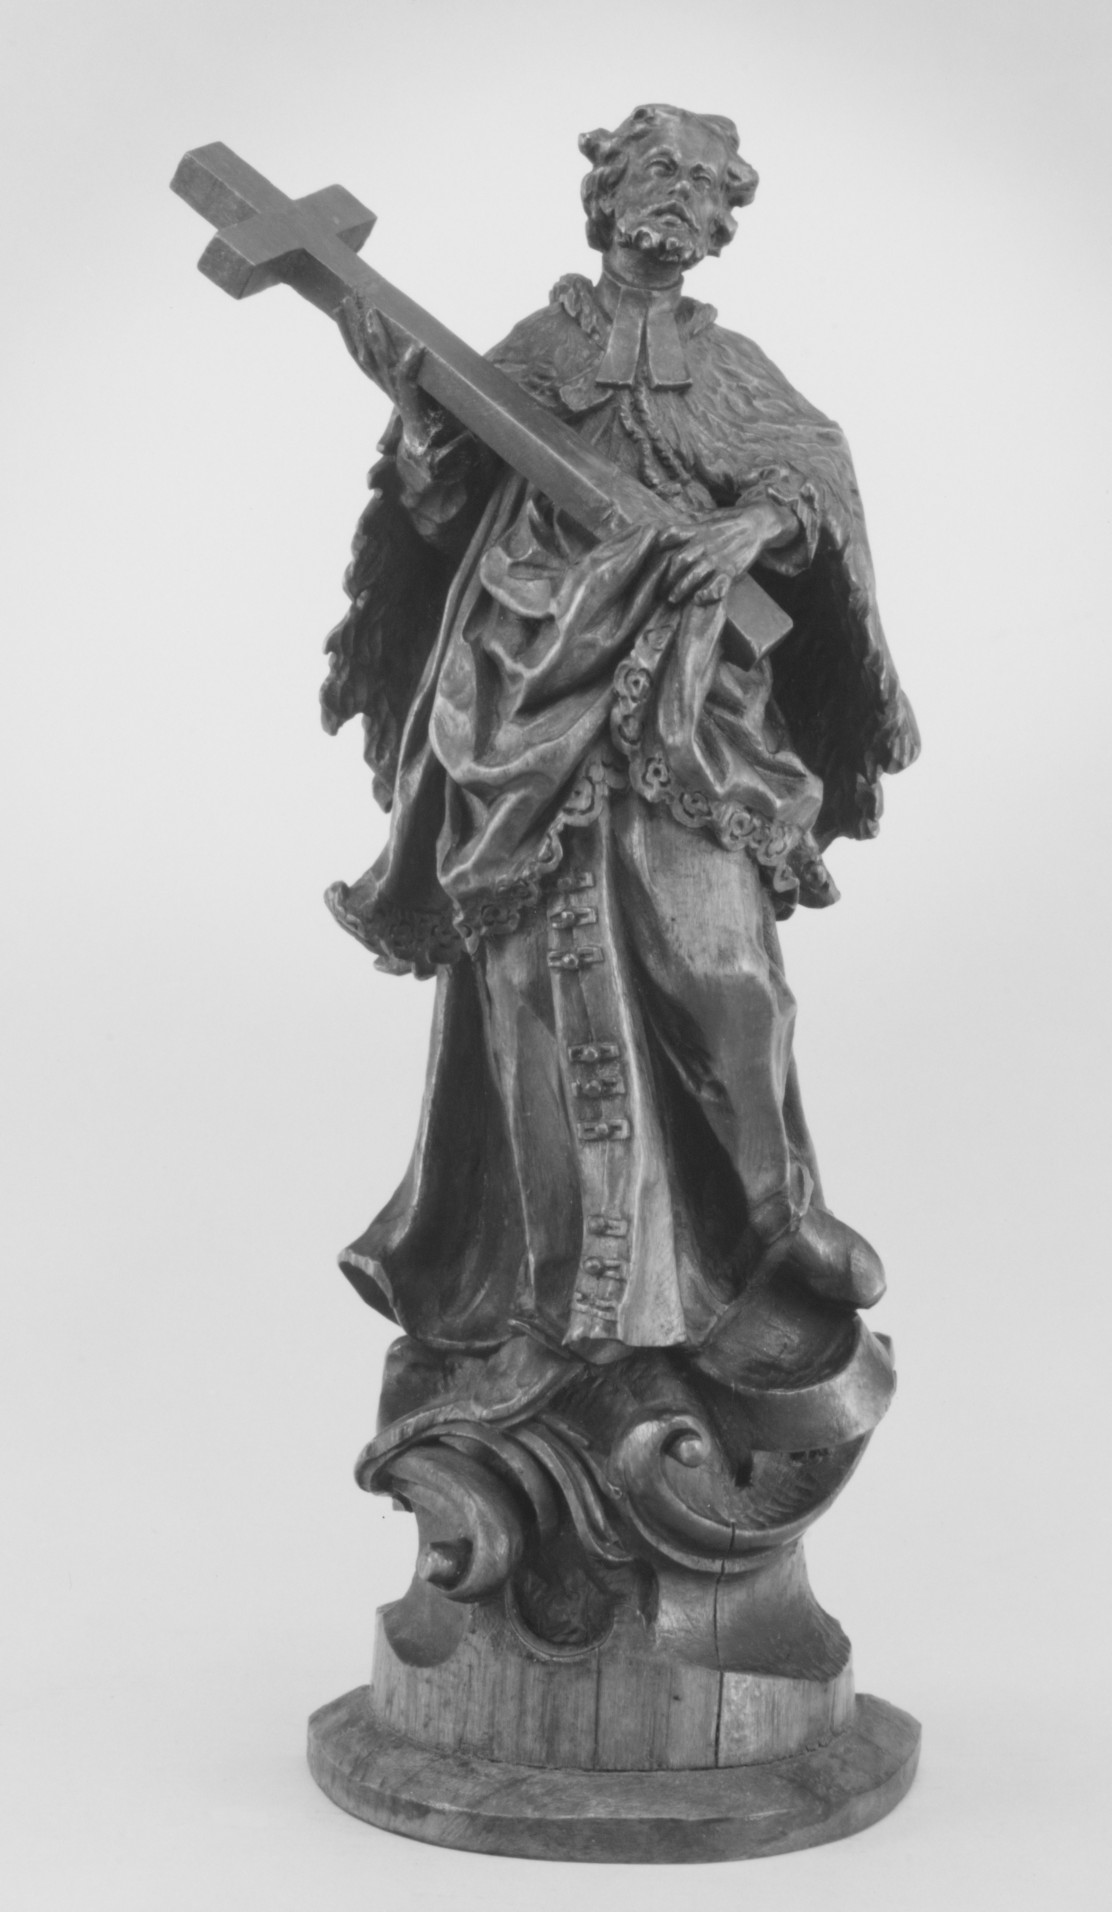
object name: statuette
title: Saint John Nepomuk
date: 1734-1766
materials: wood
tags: cross,saints